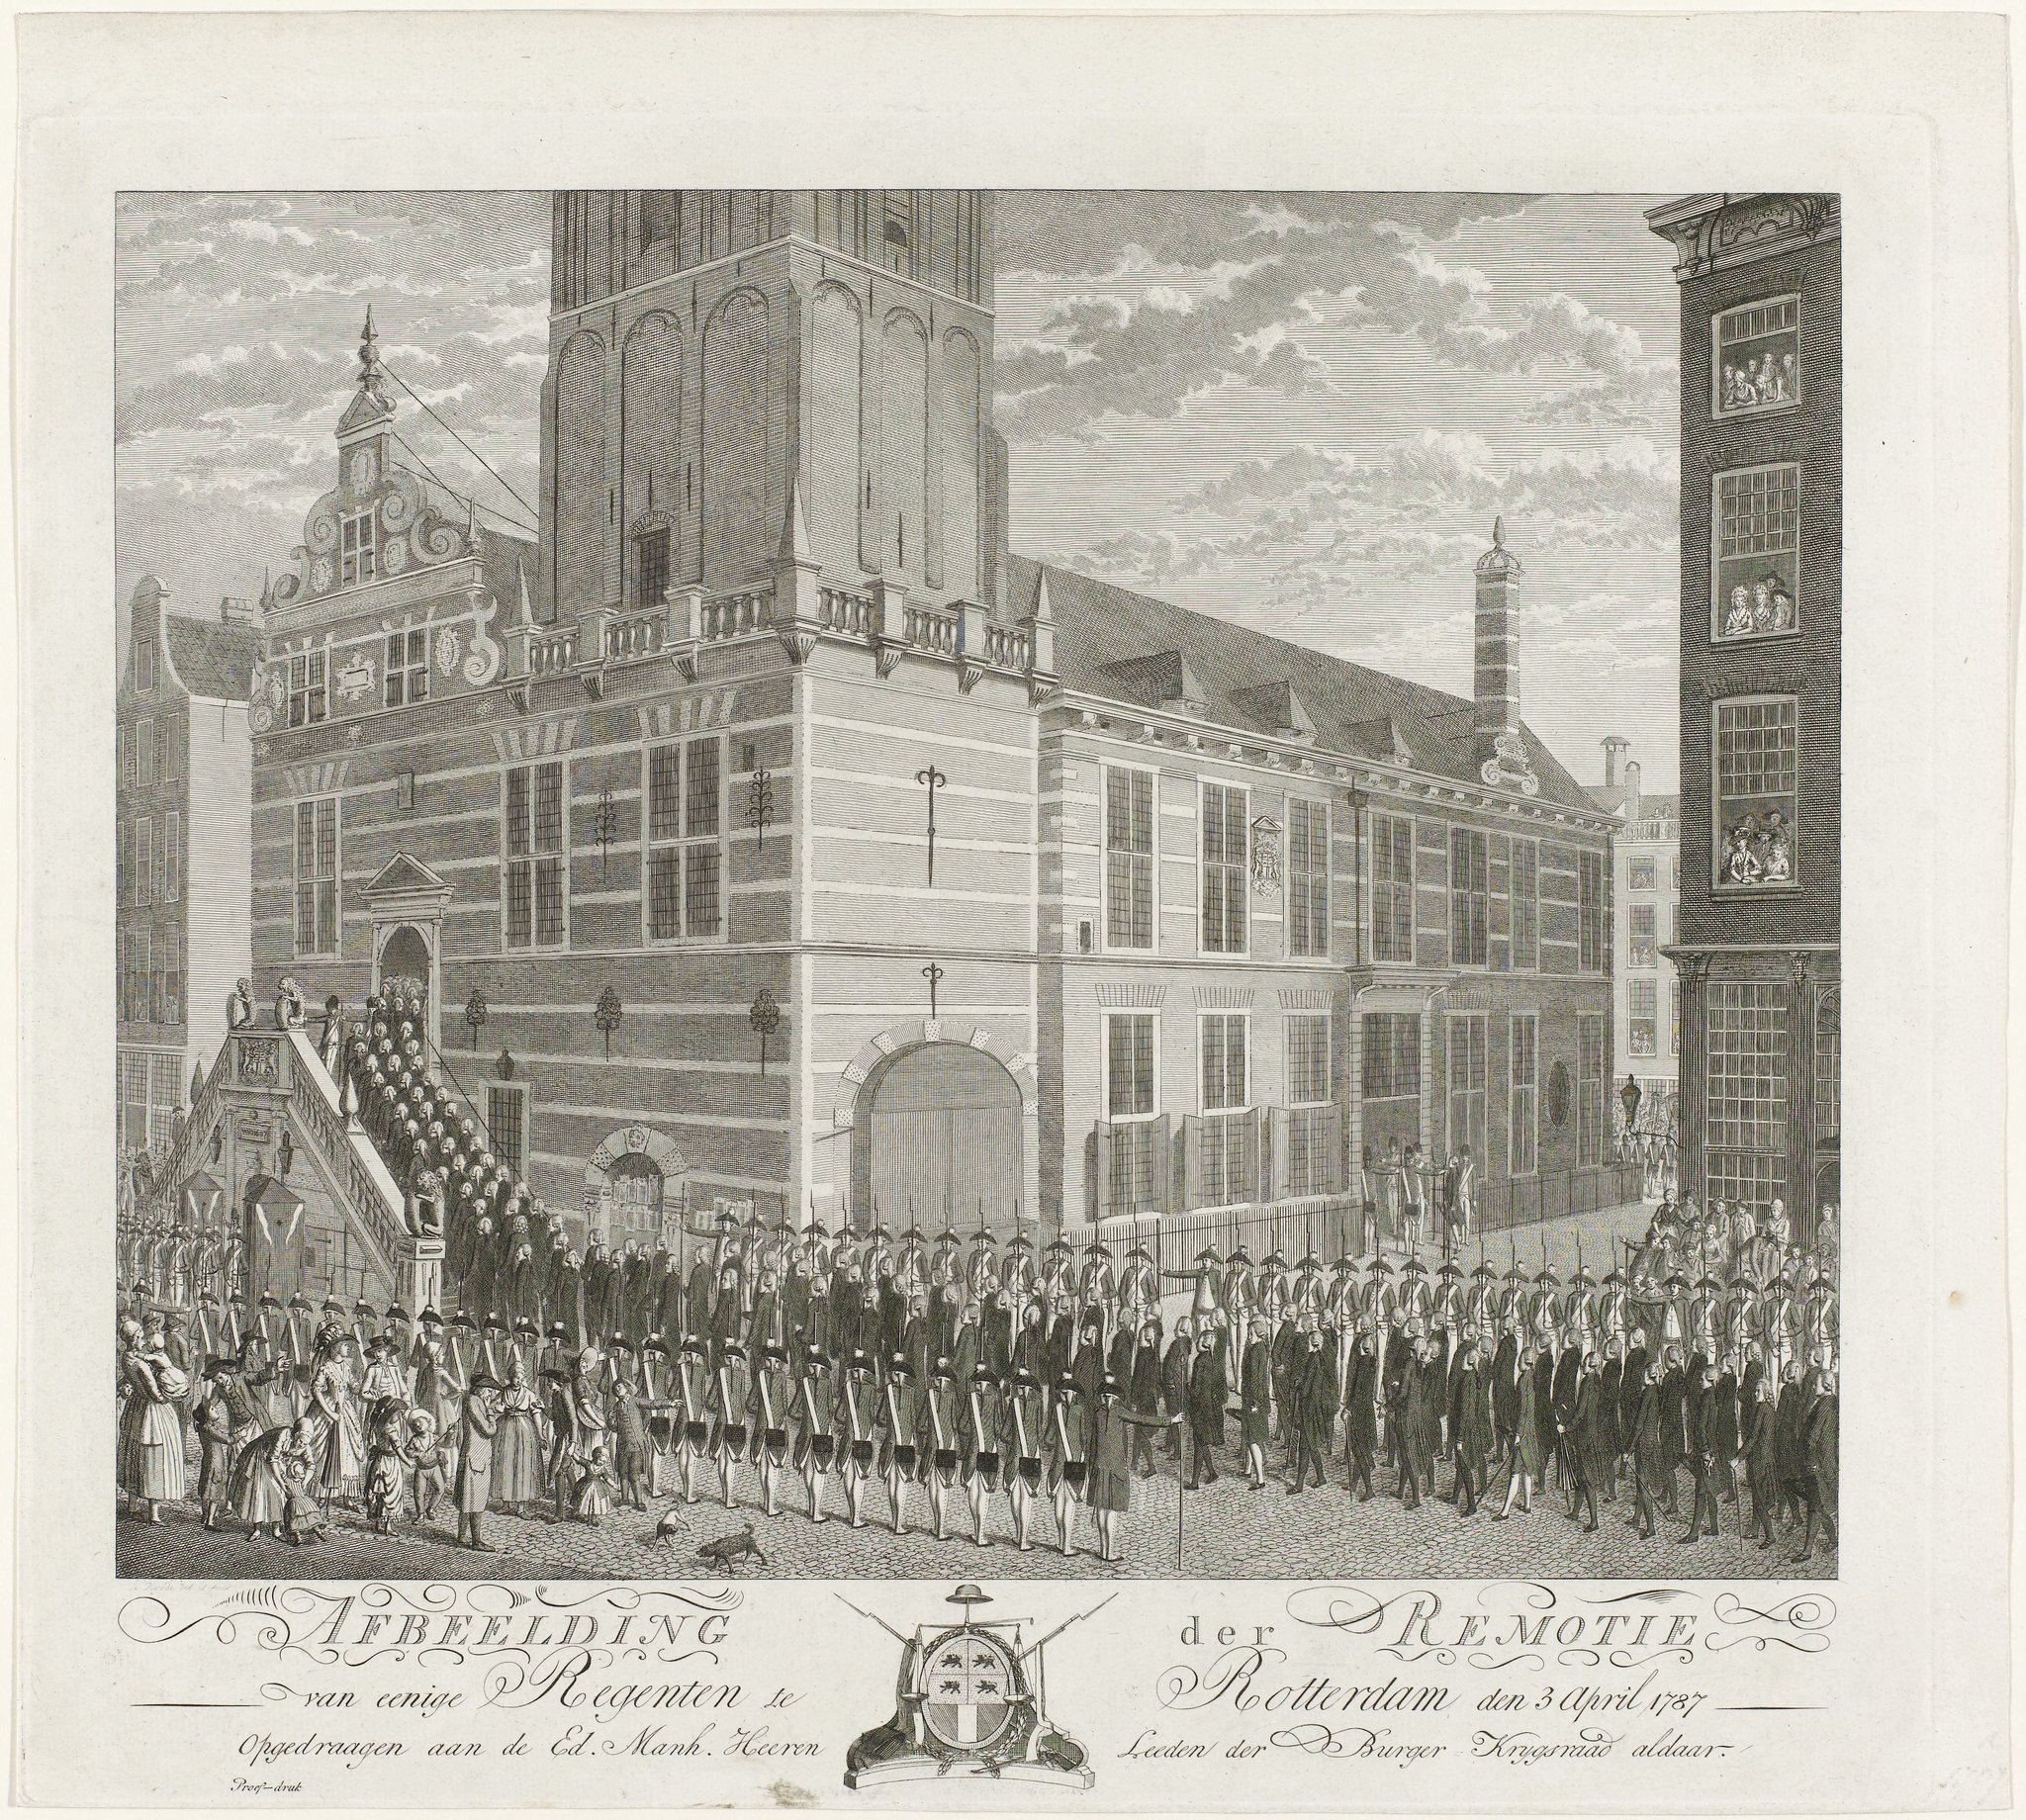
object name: print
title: Aankomst van de delegatie op het stadhuis van Rotterdam om de afzetting van enige raadsleden te eisen, 1787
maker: theodorus de roode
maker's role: draughtsman, print maker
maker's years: 1736-1793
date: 1790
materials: paper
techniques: engraving, etching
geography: northern netherlands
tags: patriots (1780-1795)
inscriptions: collector's mark: Lugt 2228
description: Aankomst van de delegatie van patriotten op het stadhuis van Rotterdam om de afzetting van enige oranjegezinde raadsleden af te dwingen, 3 april 1787. De delegatie loopt door een haag van schutters de trappen van het stadhuis op. Onderaan het wapen van een Rotterdams vrijkorps.